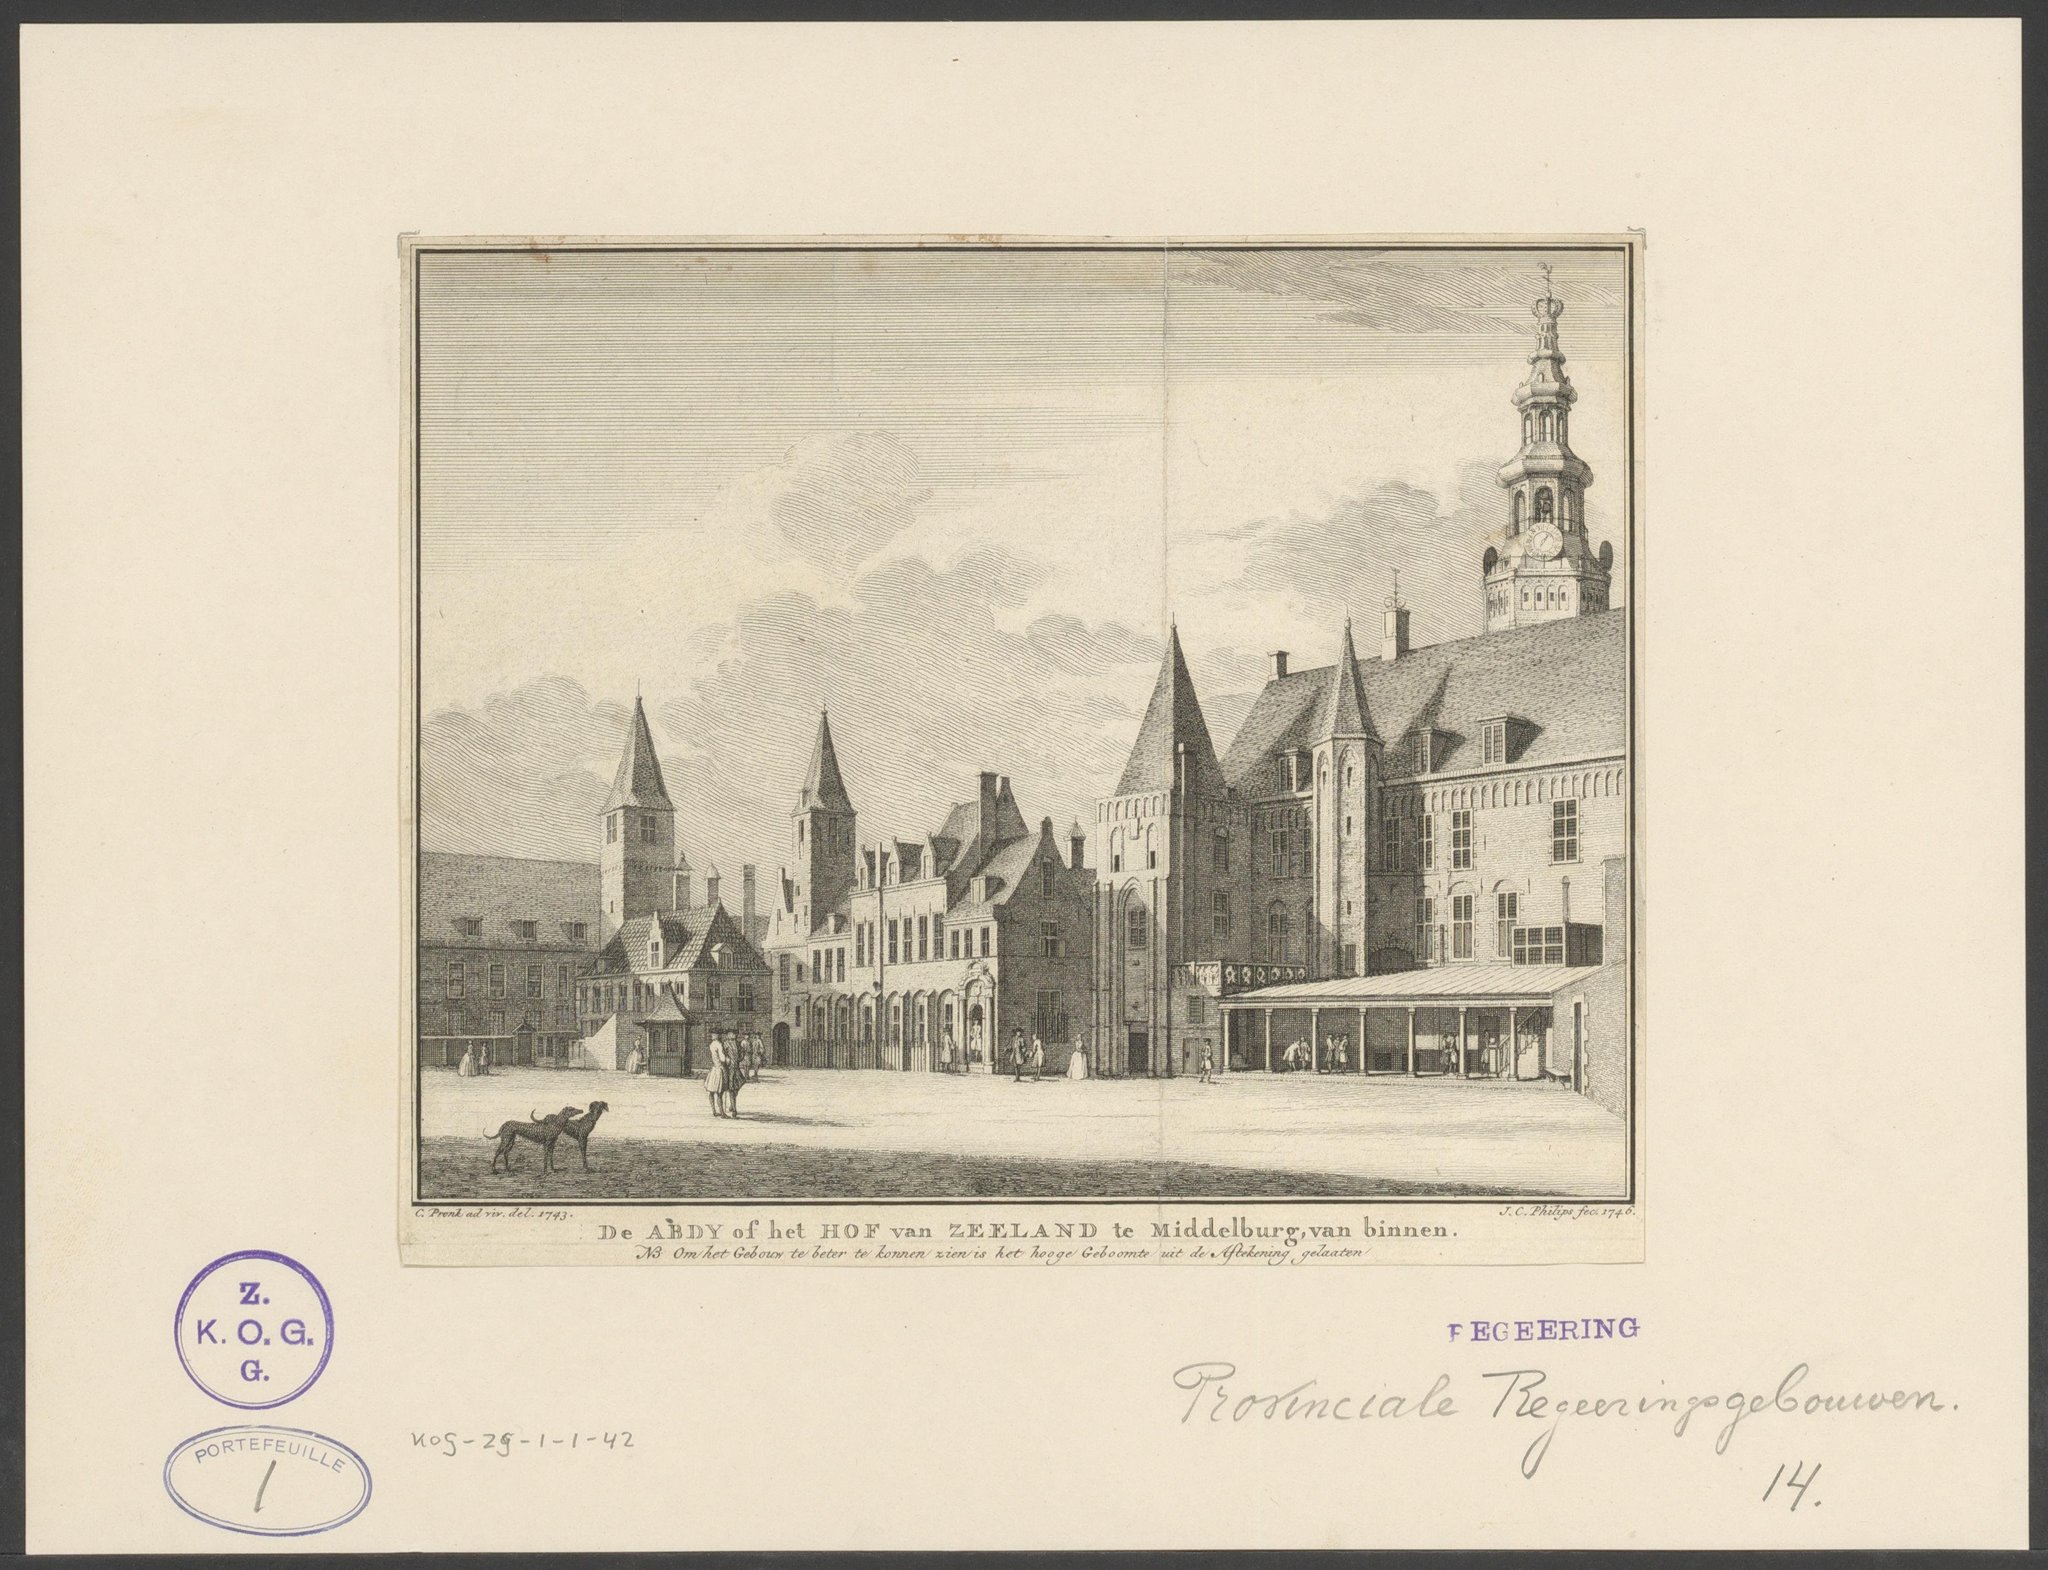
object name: print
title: De Abdy of het Hof van Zeeland te Middelburg, van binnen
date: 1746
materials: paper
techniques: etching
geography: netherlands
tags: abbey, monastery, convent ~ roman catholic church, representation of real building (either existing or having existed)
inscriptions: collector's mark: Lugt 1641, collector's mark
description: Gezicht op het Abdijplein te Middelburg, in de situatie omstreeks 1743. Het Hof van Zeeland zetelde in de gebouwen van de voormalige abdij aan het Abdijplein. Rechts op de achtergrond de Lange Jan. Onderwerpsrubrieken binnen de Atlas Zeden en Gewoonten: Regeering, Provinciale Regeeringsgebouwen.